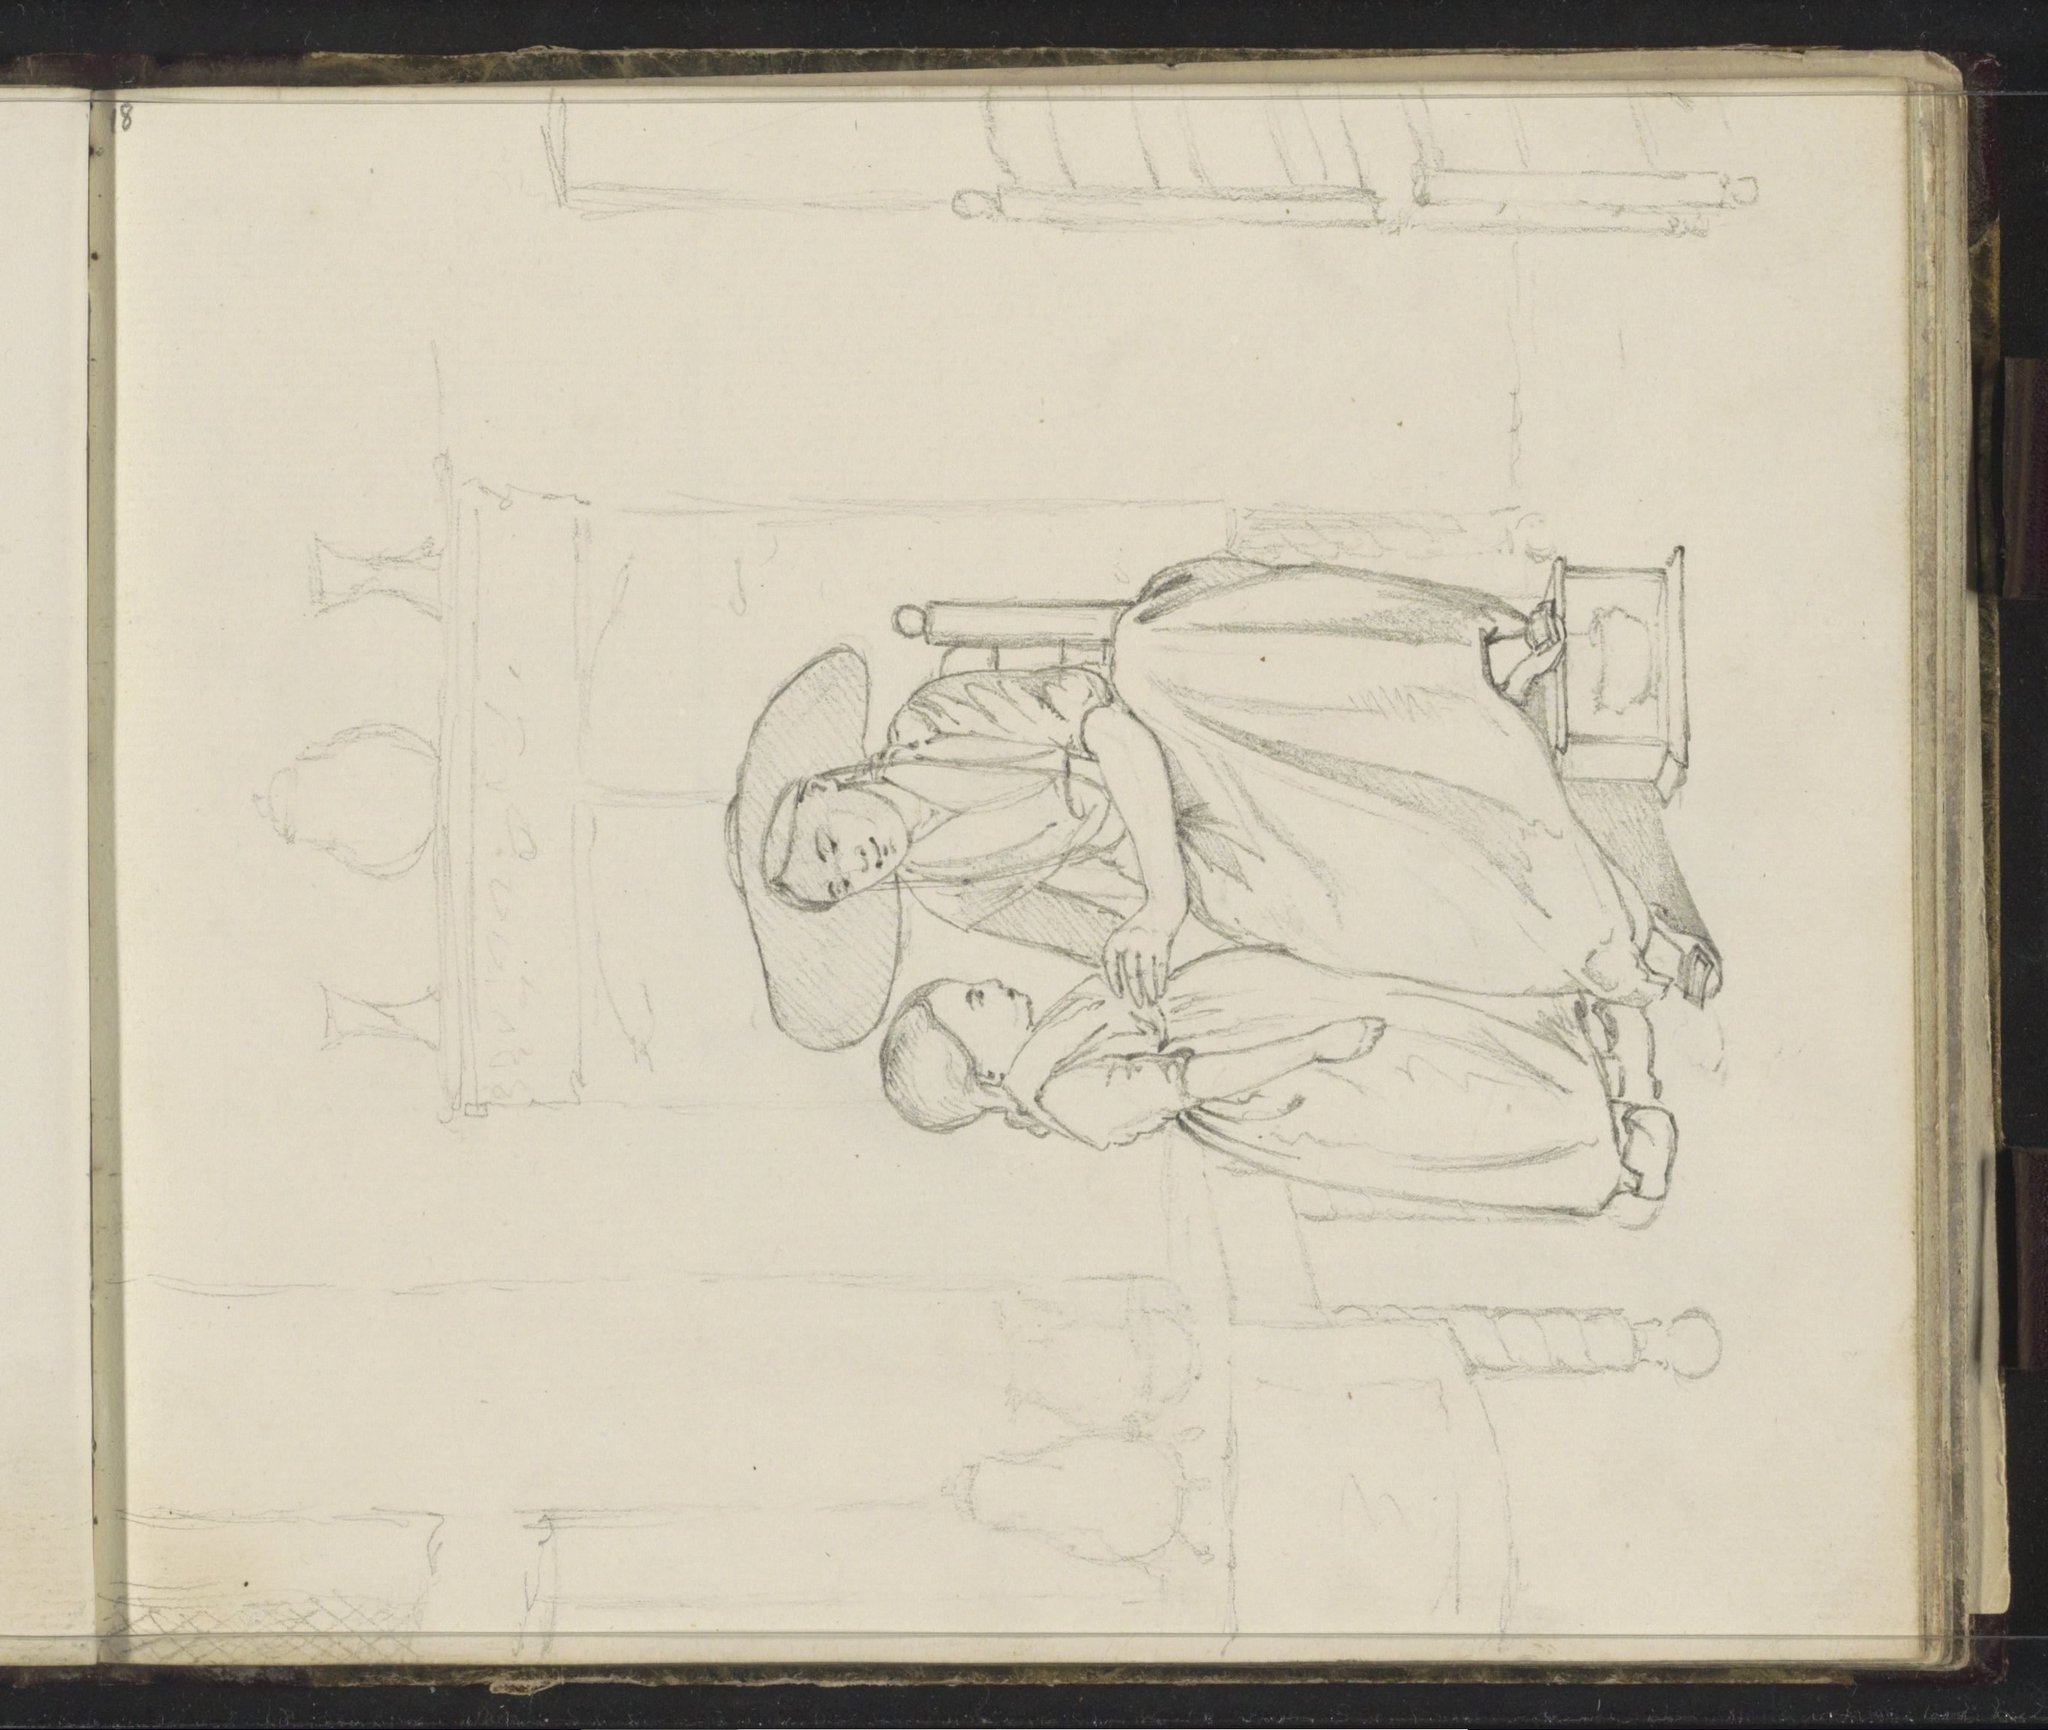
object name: sketchbook leaf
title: Boereninterieur met moeder en dochter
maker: hendrik abraham klinkhamer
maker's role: draughtsman, painter, print maker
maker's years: 1810-1872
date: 1820-1872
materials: paper, pencil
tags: interior of the house, mother and daughter(s) (family group)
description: De moeder zit op een houten stoel voor een kast en heeft haar linker voet op een stoof. Ze buigt zich richting een meisje op klompen dat naast haar staat. Blad 18 recto uit een schetsboek met 39 bladen.